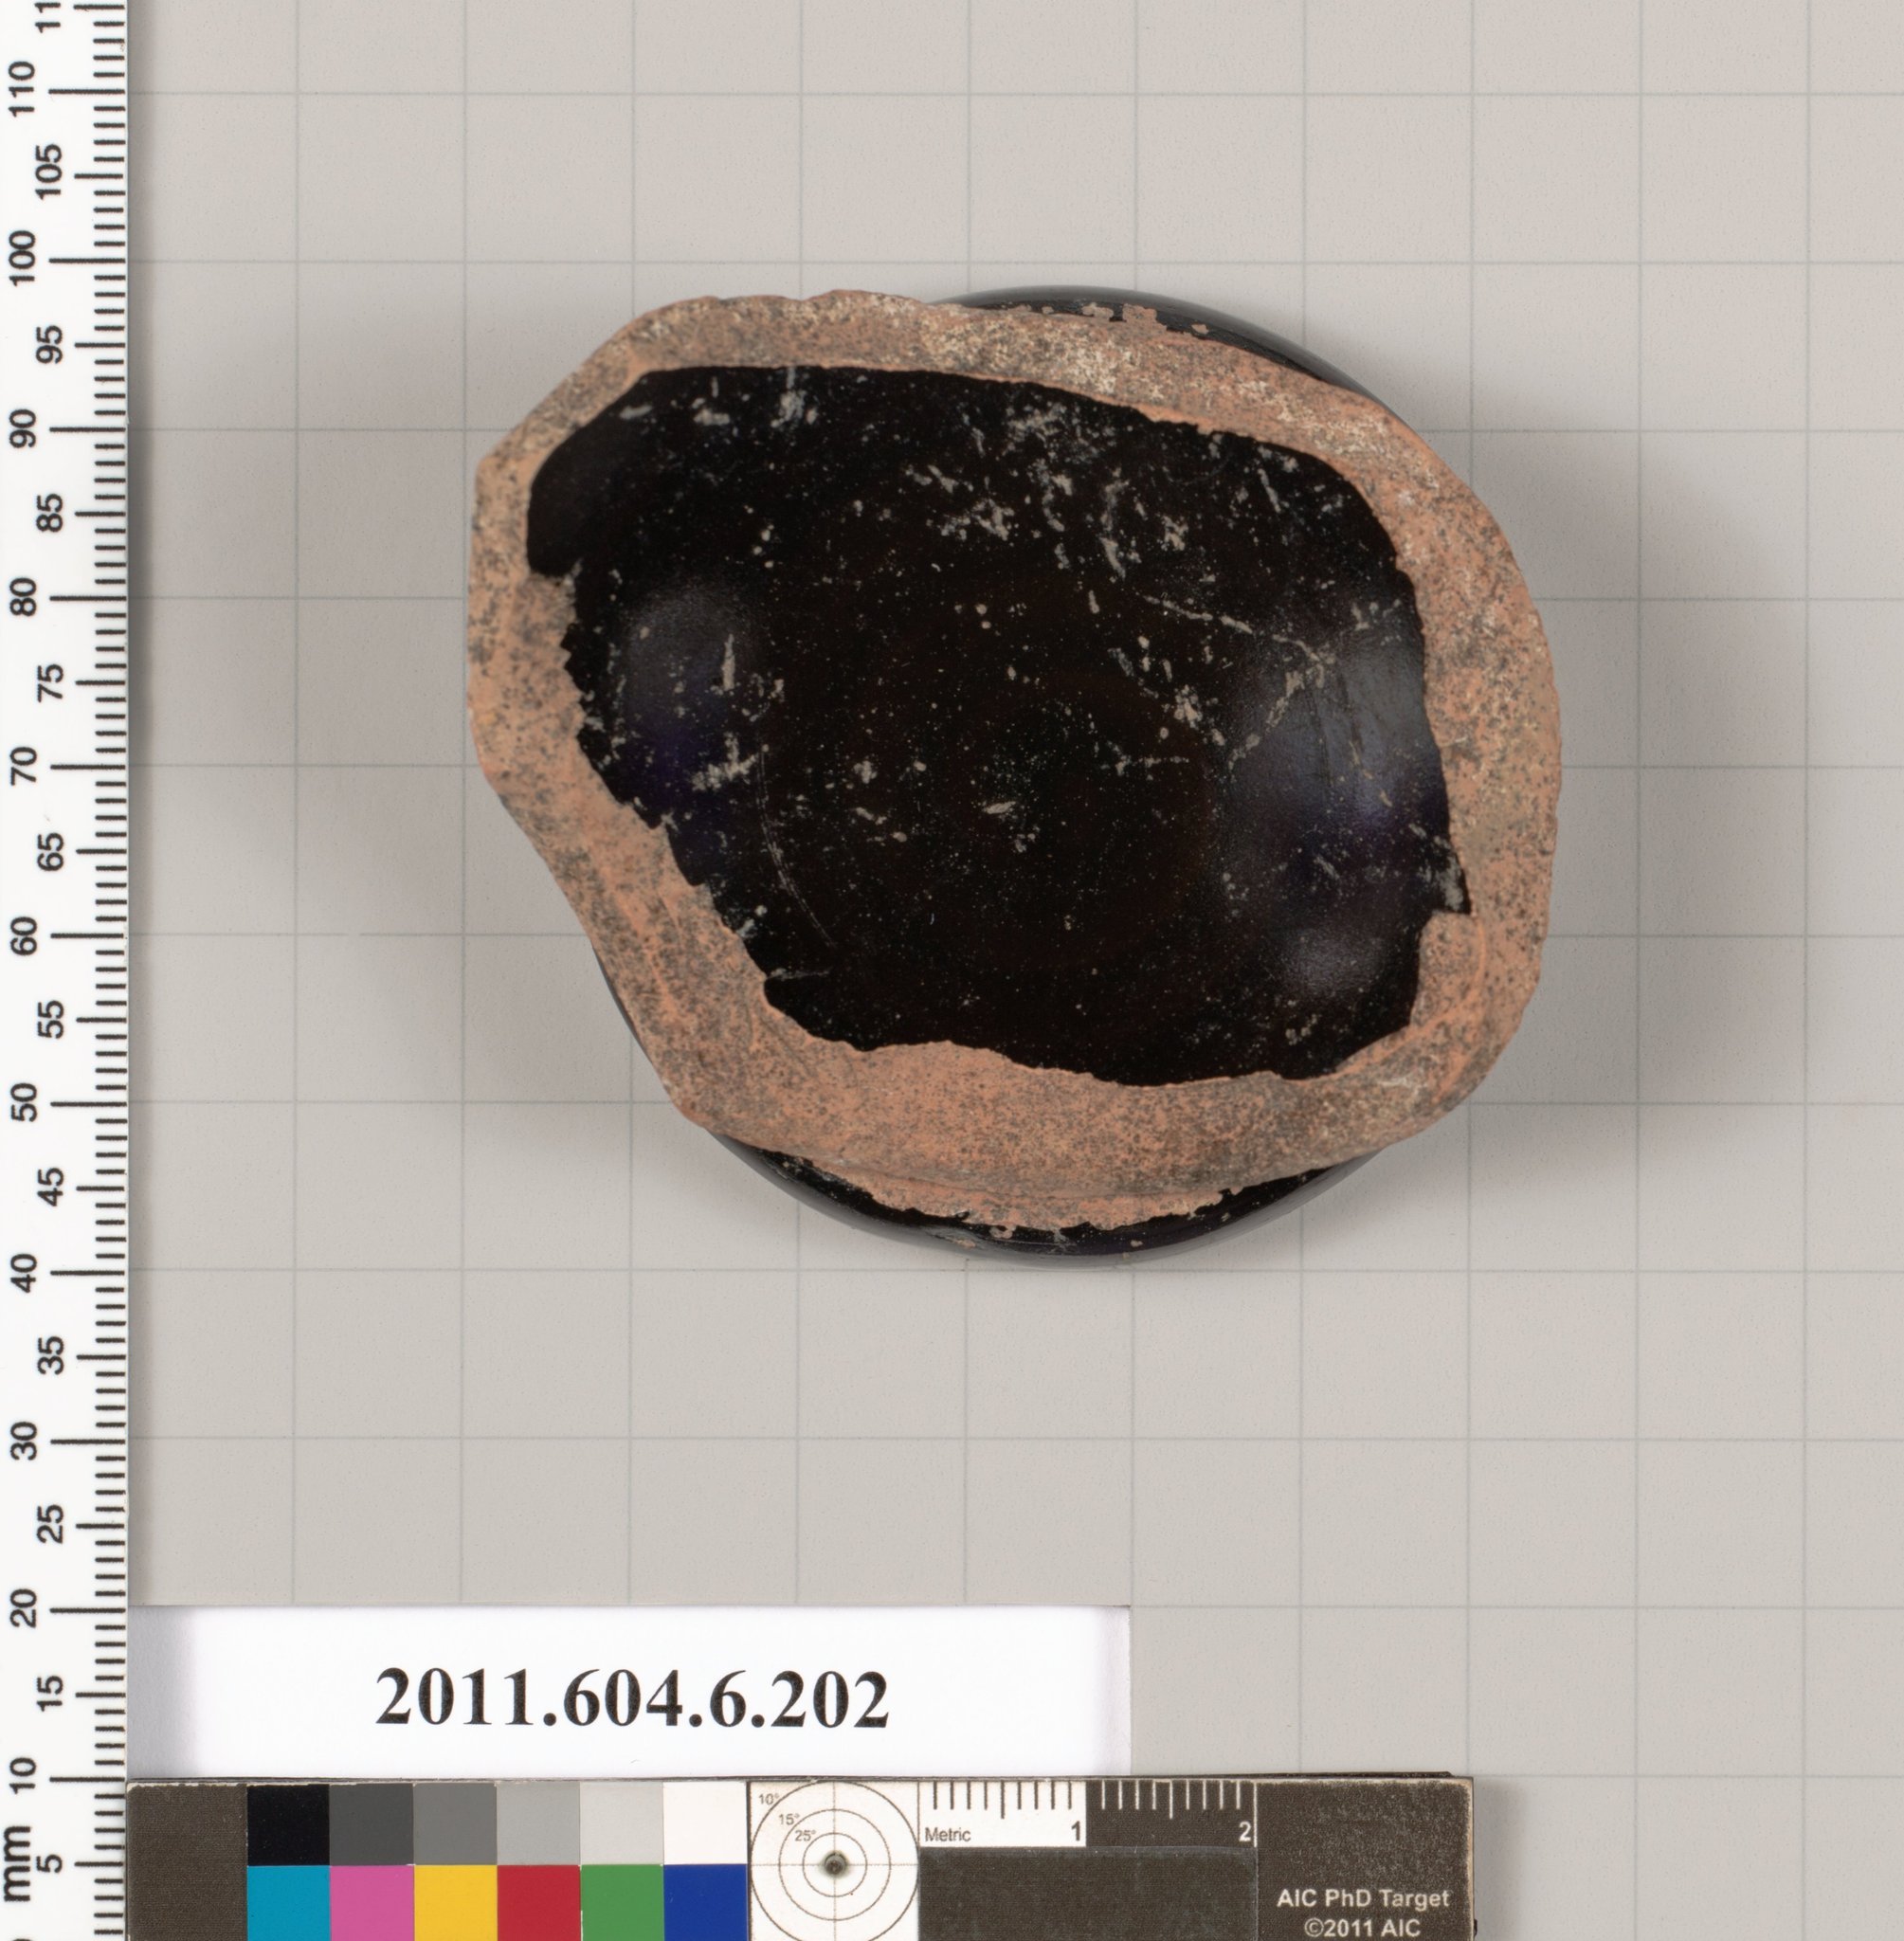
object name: skyphos fragment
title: Terracotta fragment of a skyphos (deep drinking cup)?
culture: greek, attic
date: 500-401 BCE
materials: terracotta